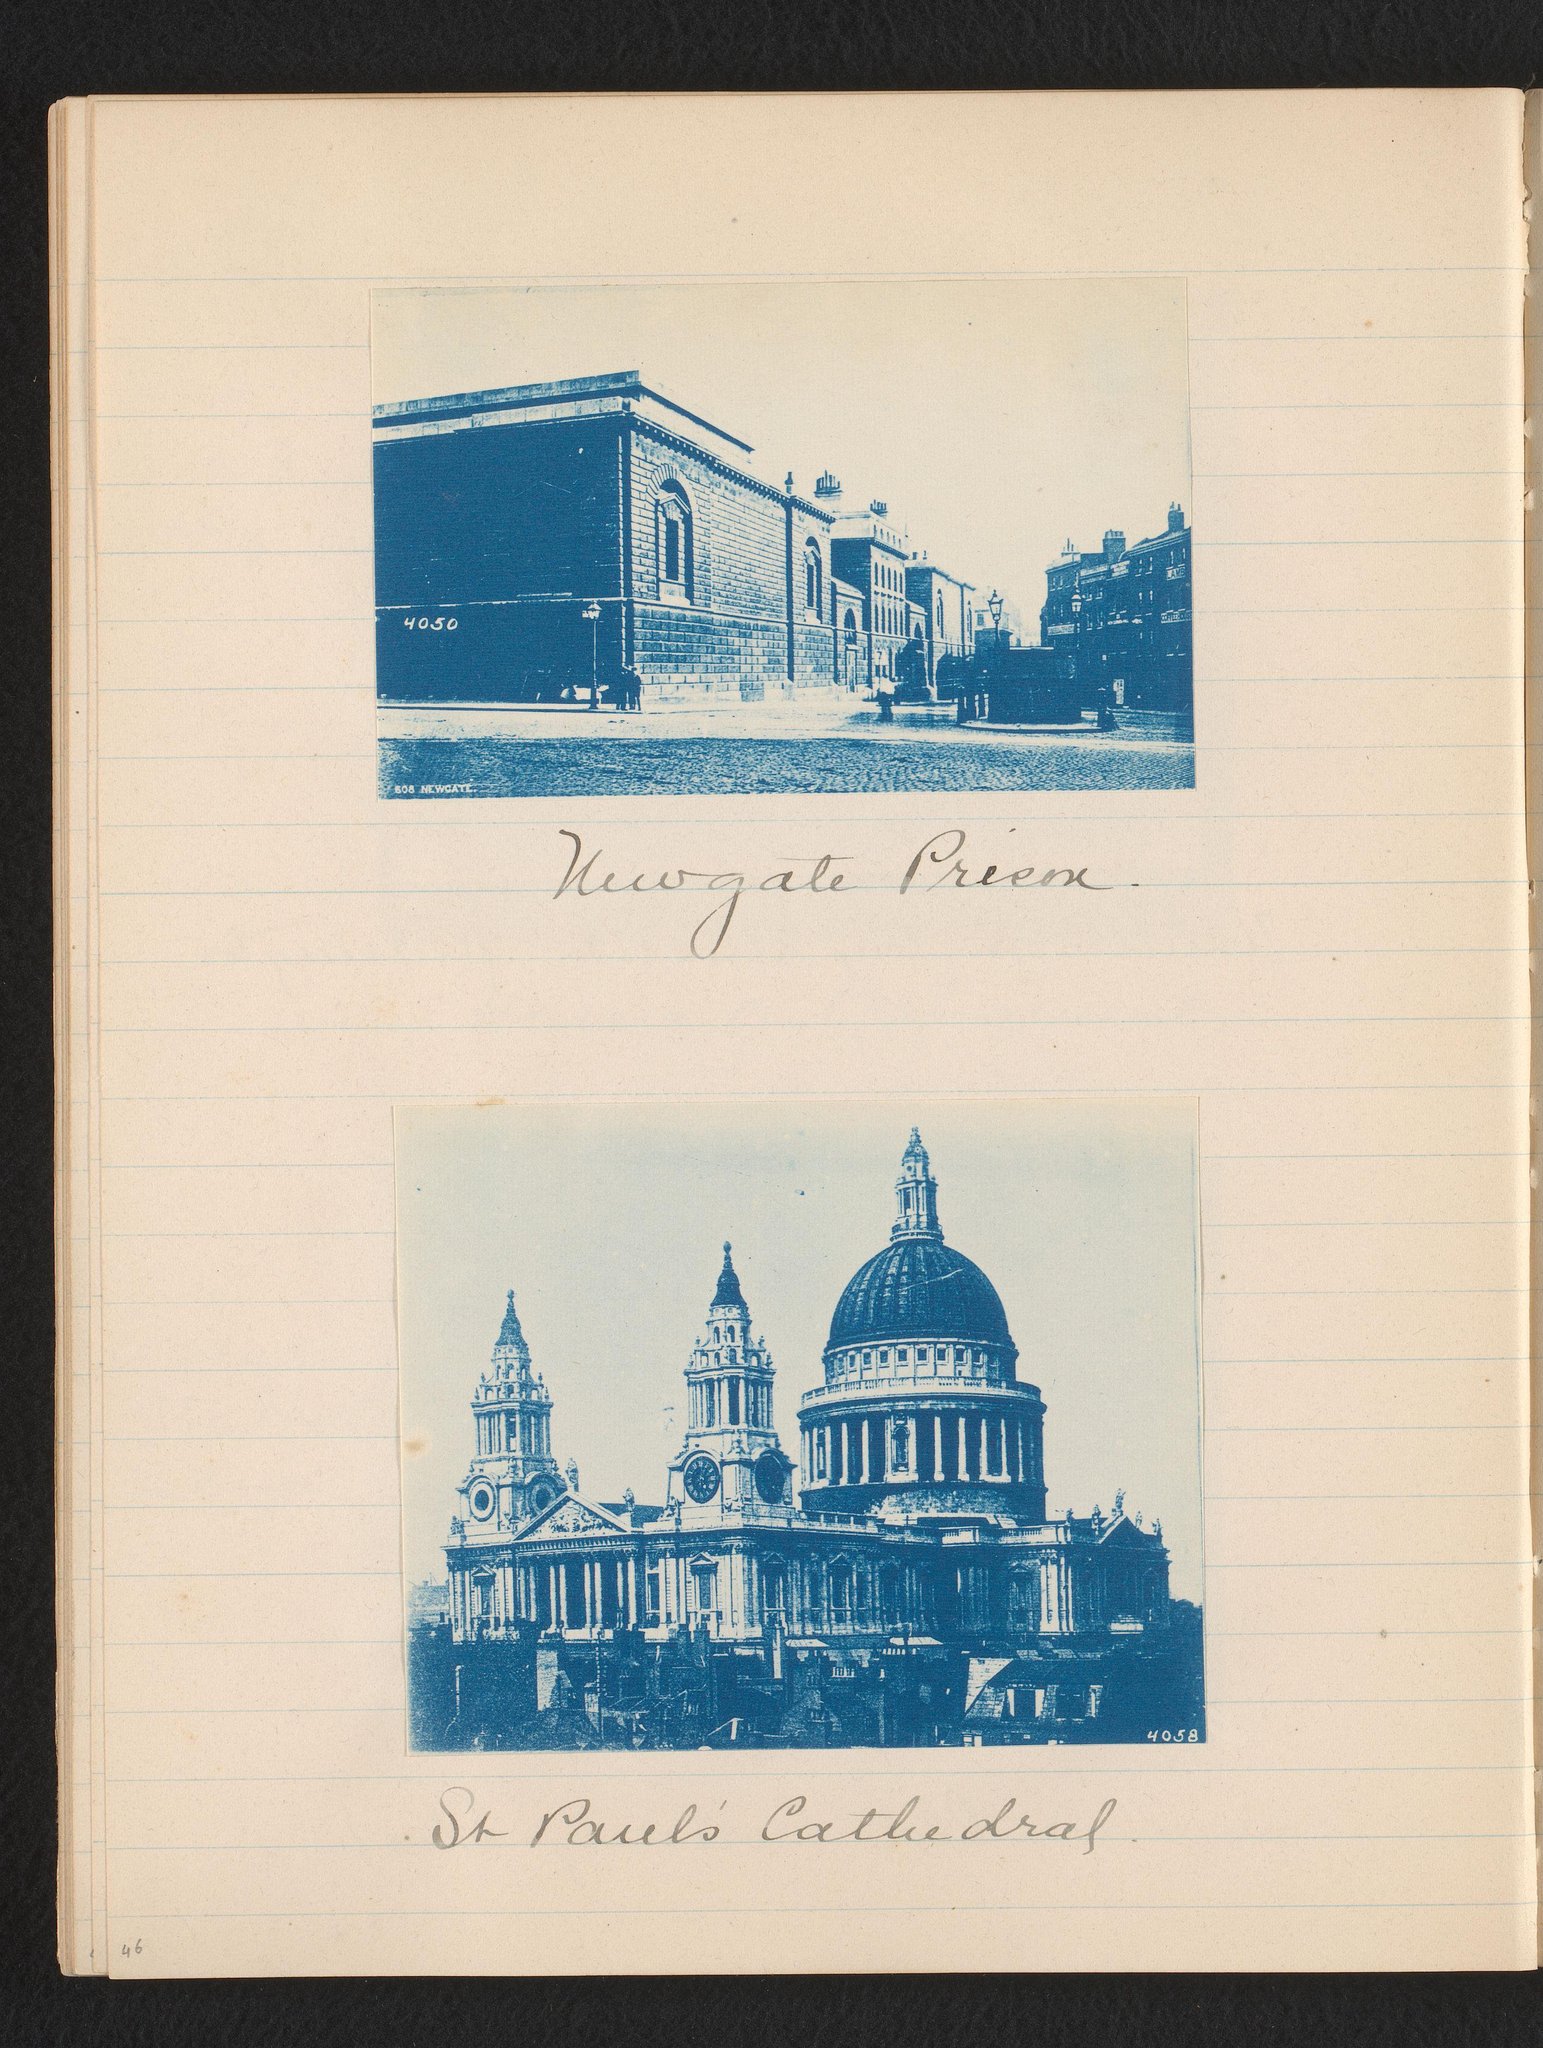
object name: album leaf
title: Twee foto's van Newgate Prison en Saint Paul's Cathedral, Londen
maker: Anonymous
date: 1901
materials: paper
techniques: cyanotype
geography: london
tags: prison, jail, church (exterior)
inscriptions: inscription: ‘Newgate Prison./ St Paul's Cathedral.’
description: Deze foto's maken deel uit van een album.